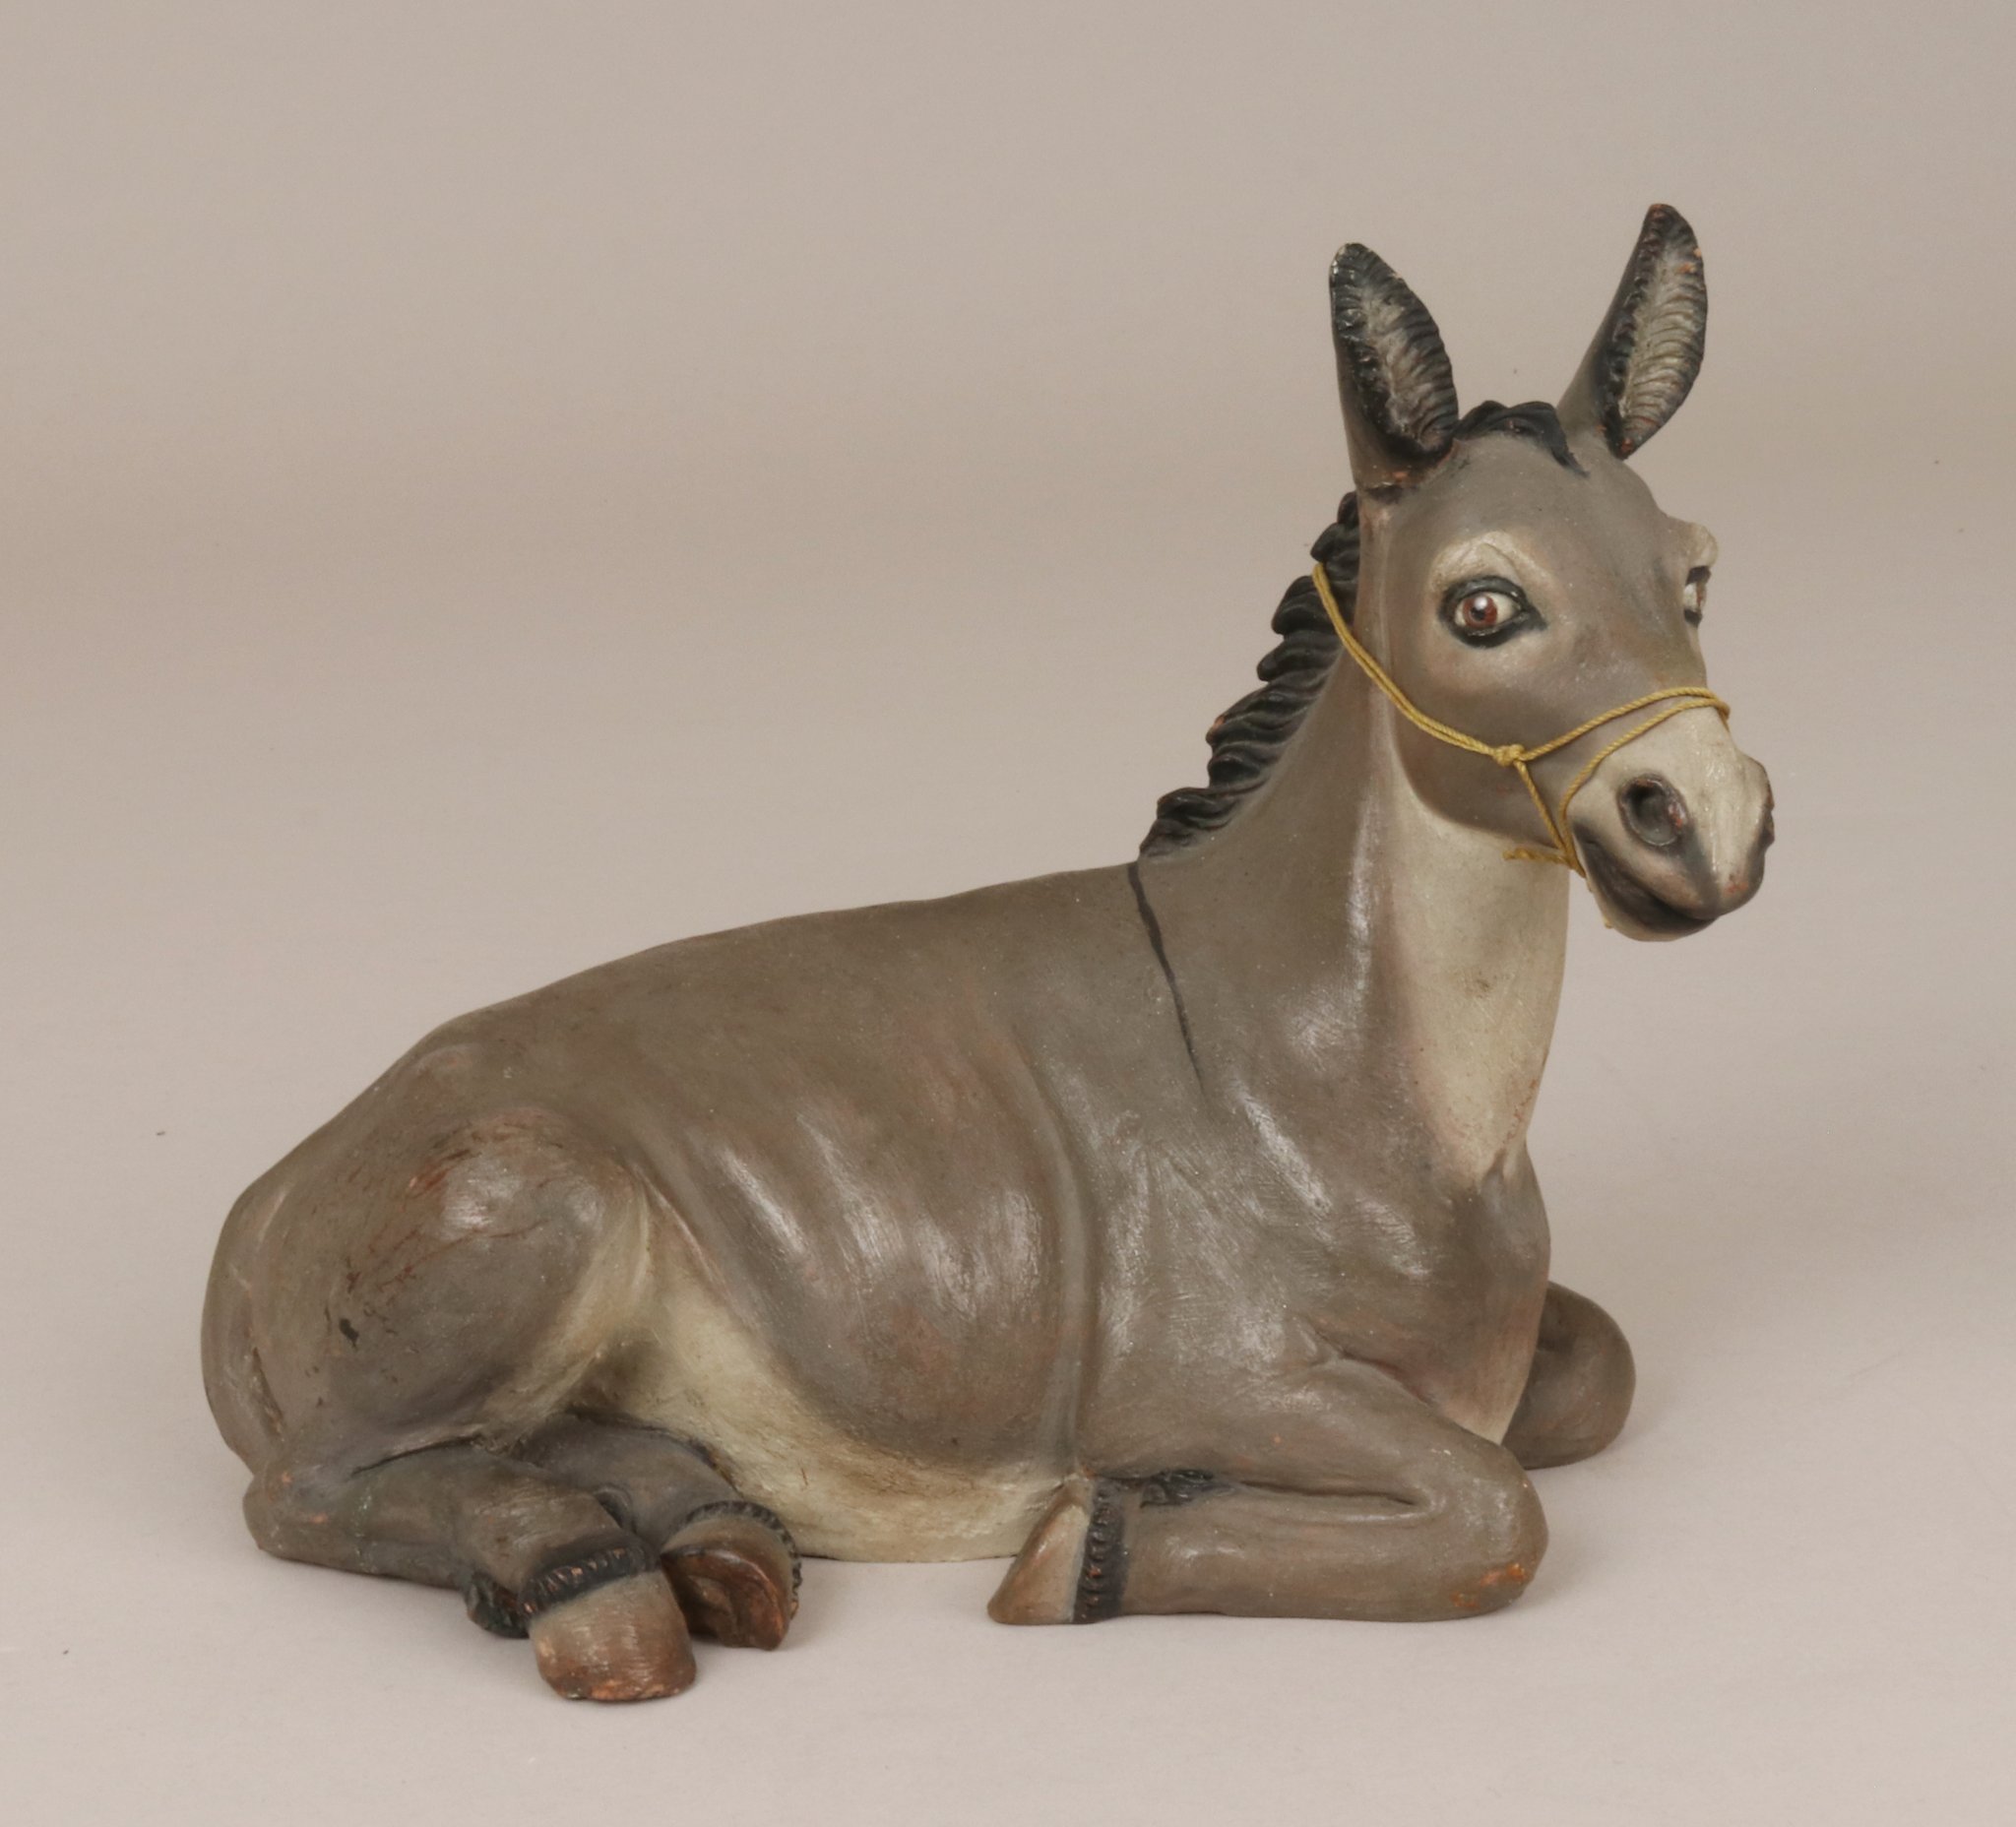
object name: crèche figure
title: Seated donkey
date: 1701-1800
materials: terracotta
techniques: polychrome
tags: donkeys